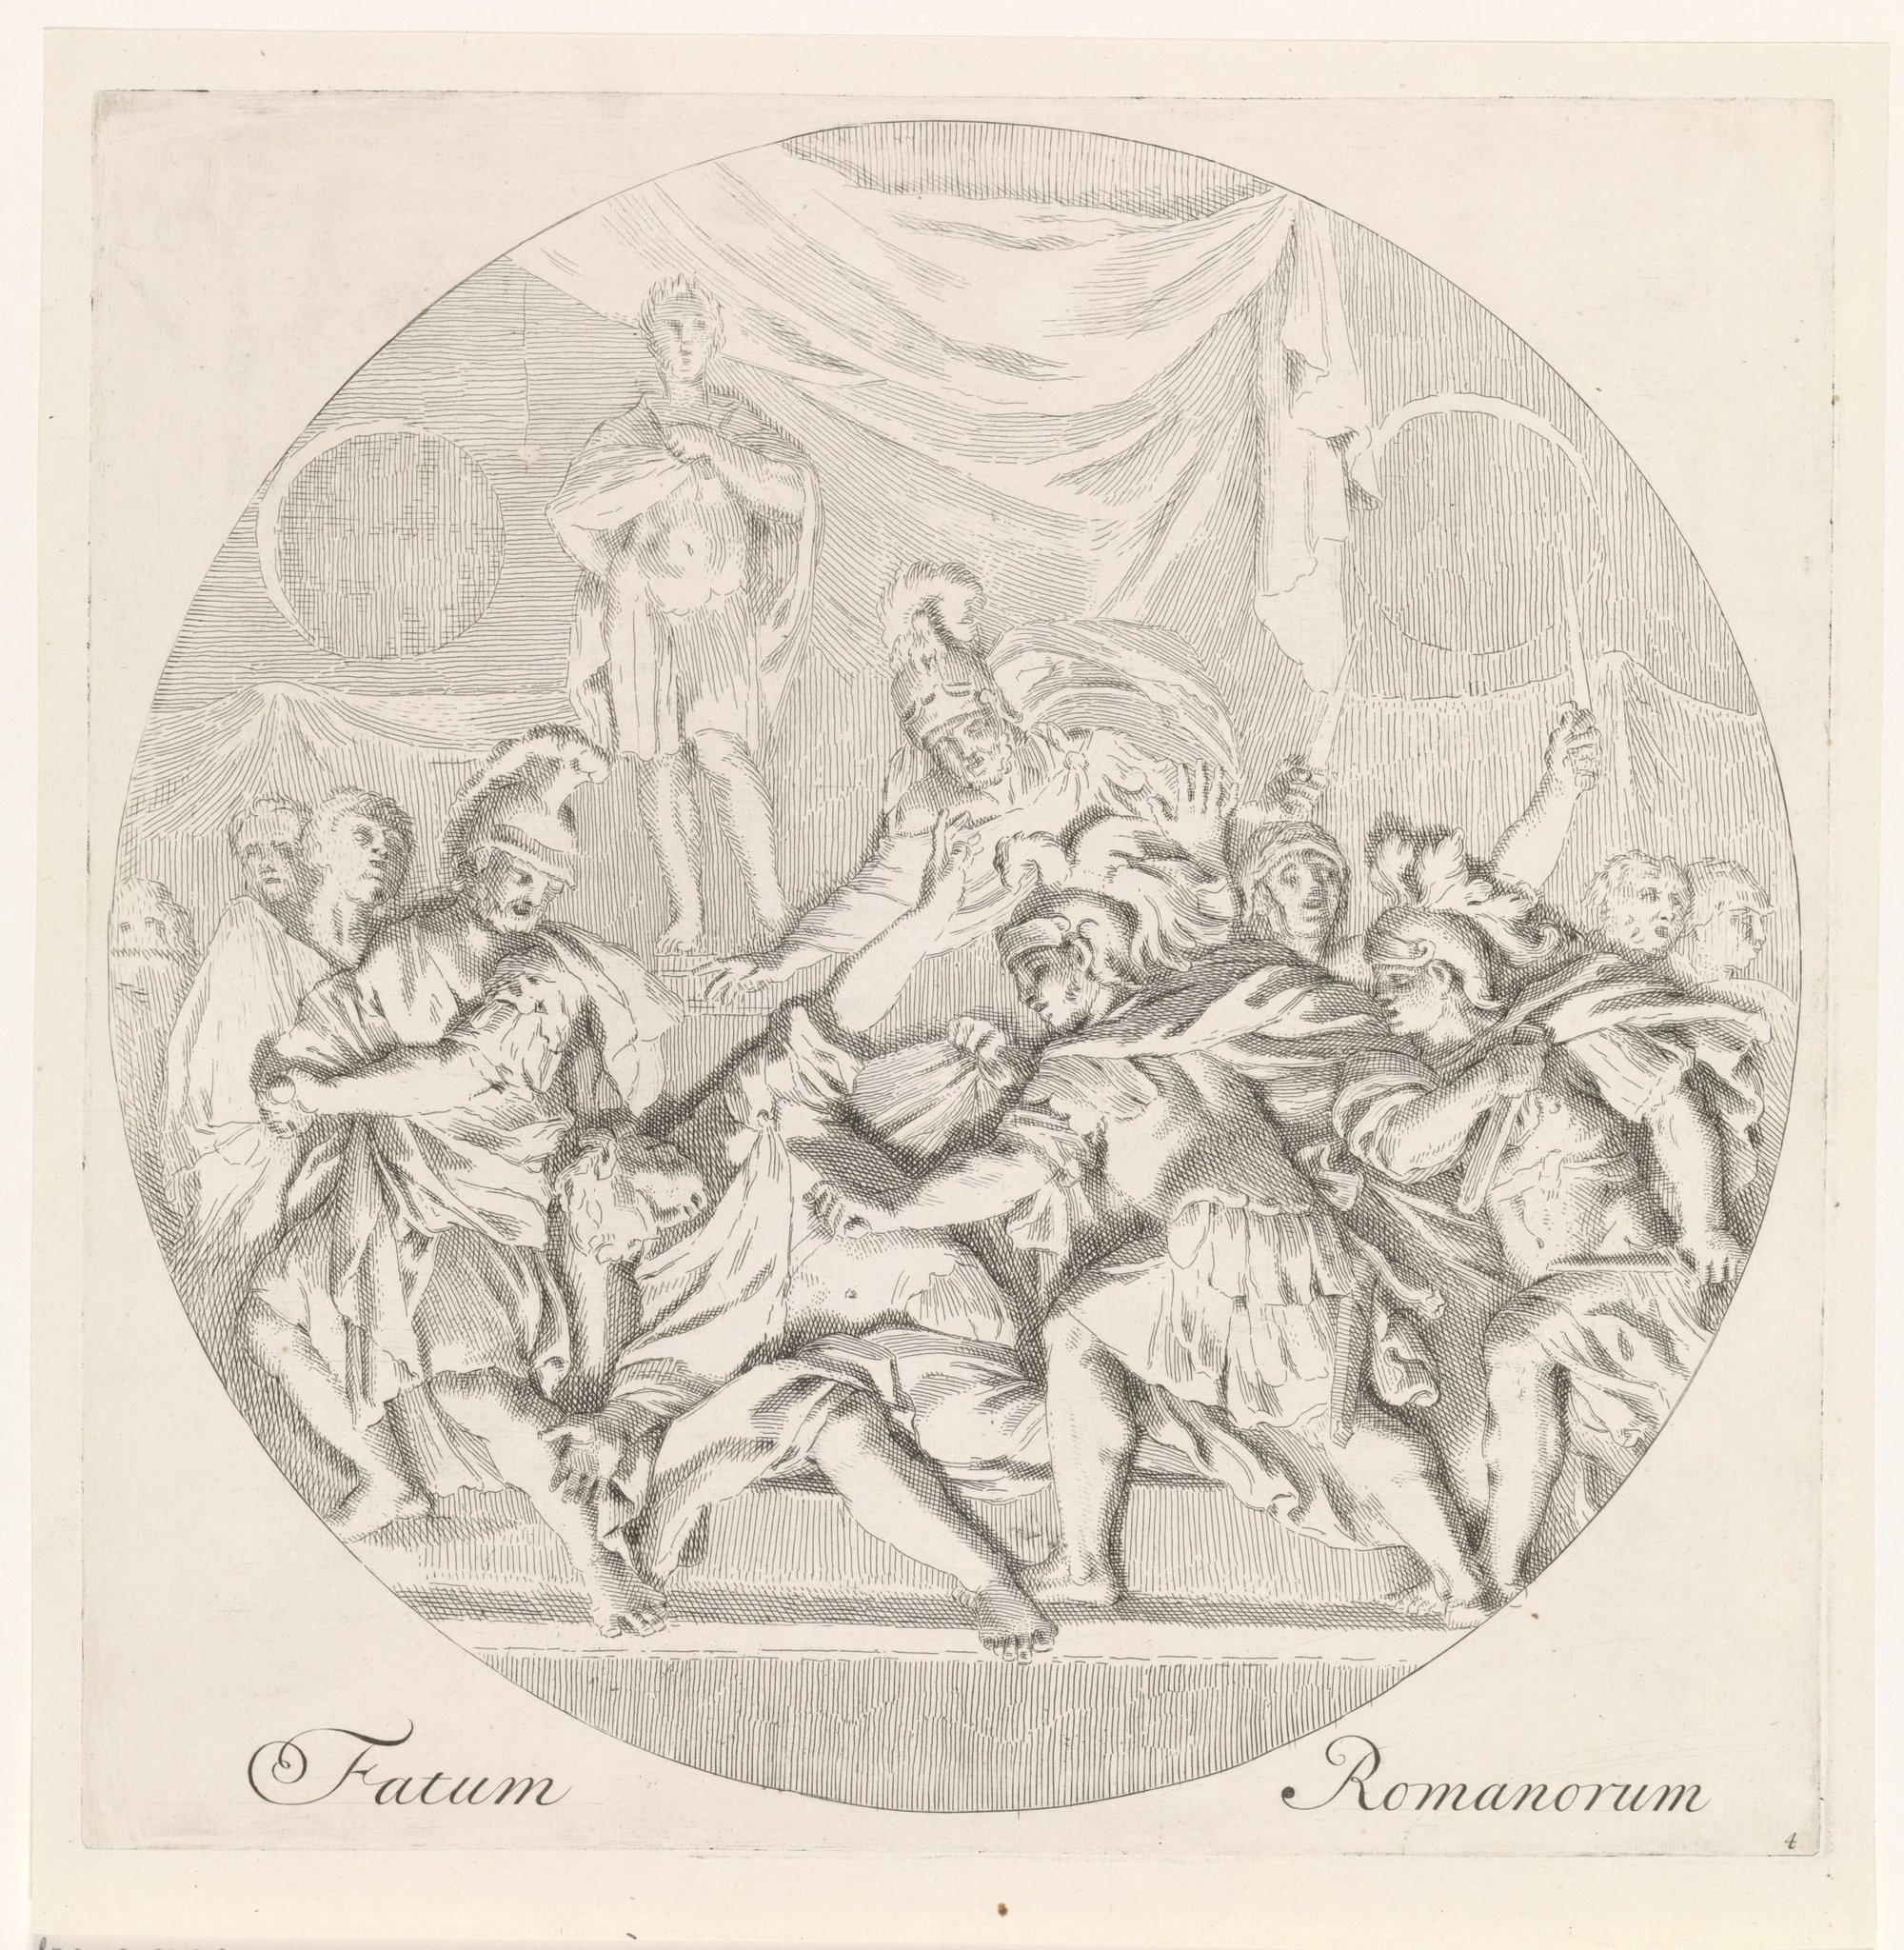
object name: print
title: Moord op Julius Caesar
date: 1684-1726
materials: paper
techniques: etching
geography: amsterdam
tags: death of caesar, i.e. the murder of caesar: he is slain in the senate at the foot of pompey's statue, exclaiming 'et tu brute'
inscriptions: collector's mark: Lugt 2228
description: Ronde voorstelling. De moord op Julius Caesar door Brutus en andere senatoren, Op de achtergrond het standbeeld van Pompeius. De prent is naar een verloren bas-reliëf van Gerard de Lairesse en maakt deel uit van een vierdelige serie met als onderwerp de ondergang van wereldrijken in de klassieke oudheid.